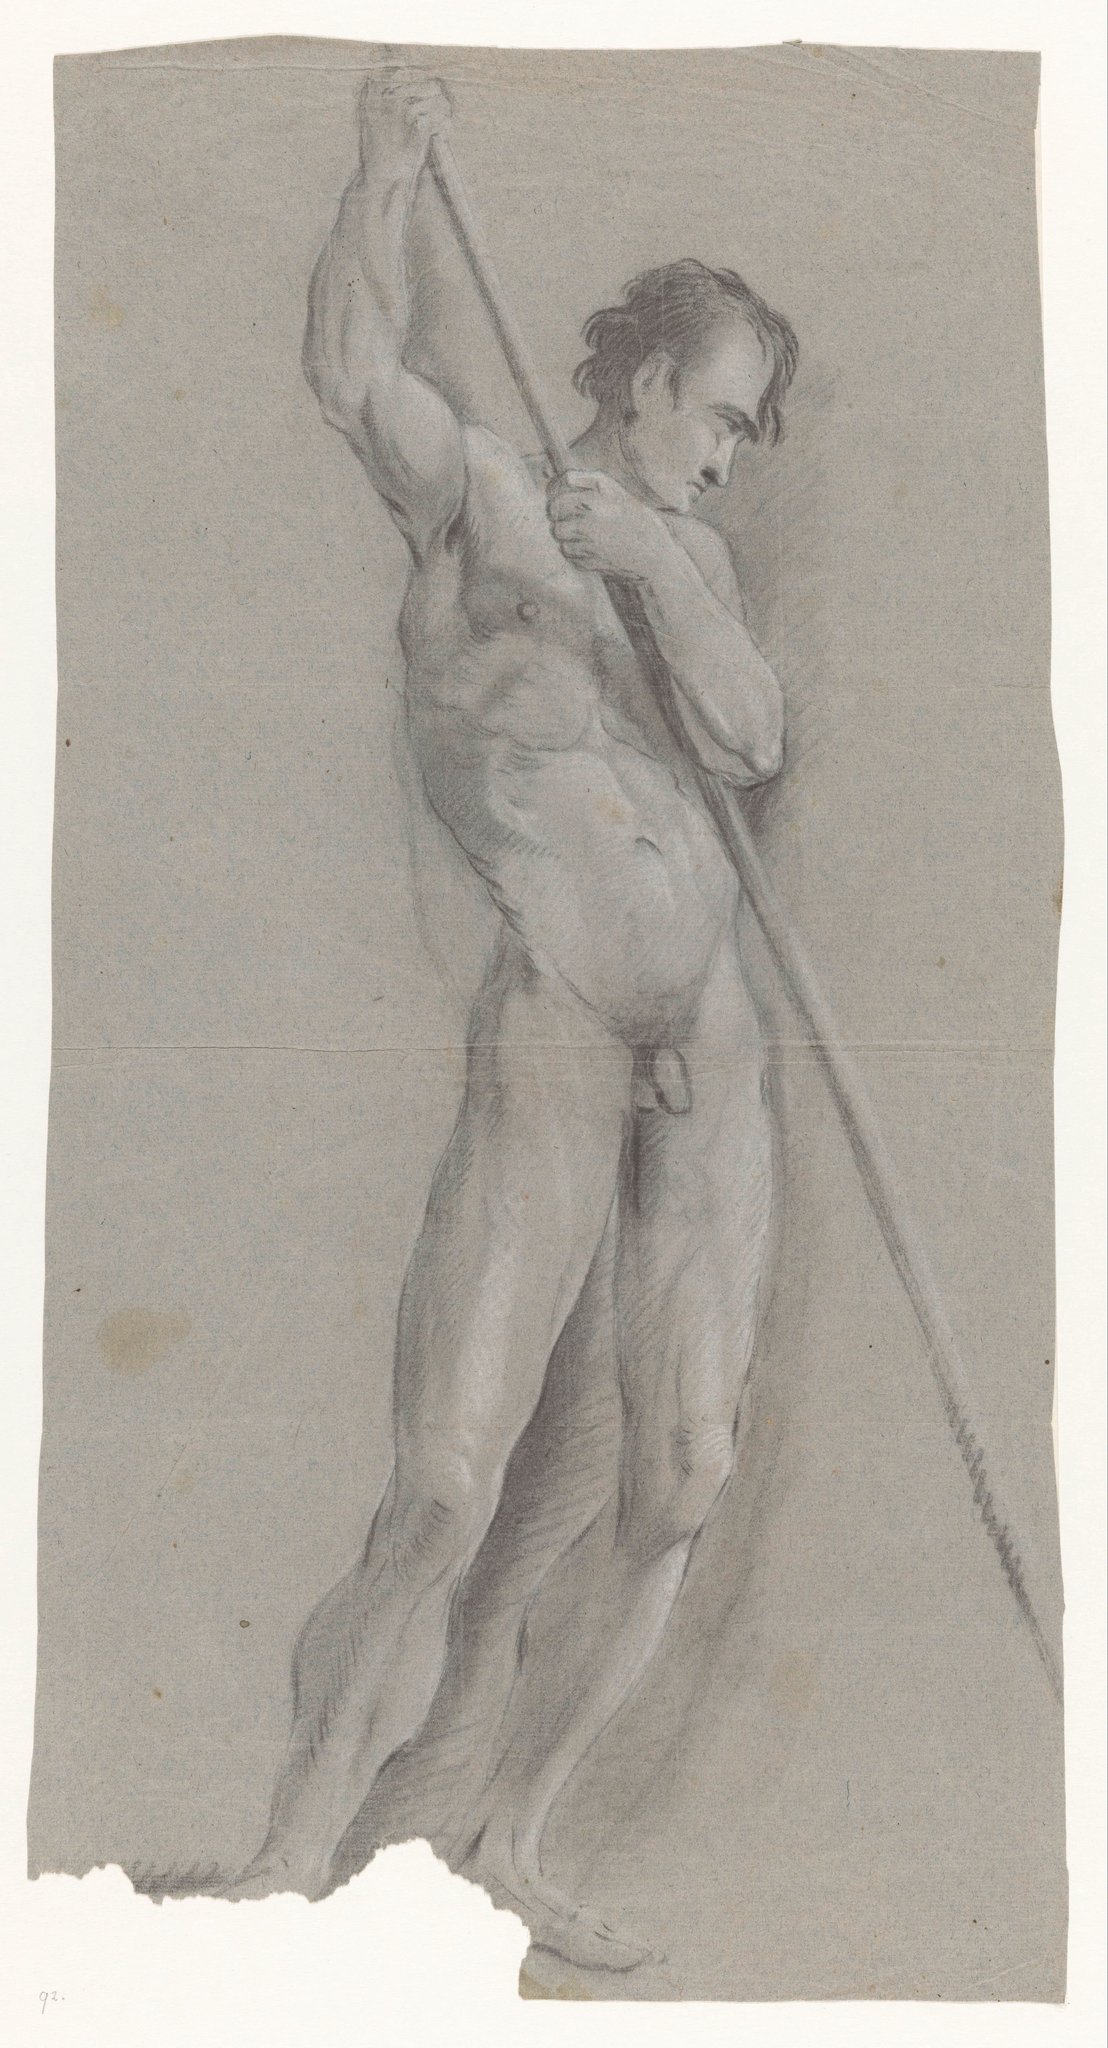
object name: drawing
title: Naakte man met stok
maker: jan brandes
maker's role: draughtsman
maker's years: 1743-1808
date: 1787-1808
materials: chalk, paper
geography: skälsebo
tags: standing figure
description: Wellicht is dit een tekening van de broer van de tekenaar: Carel Brandes.